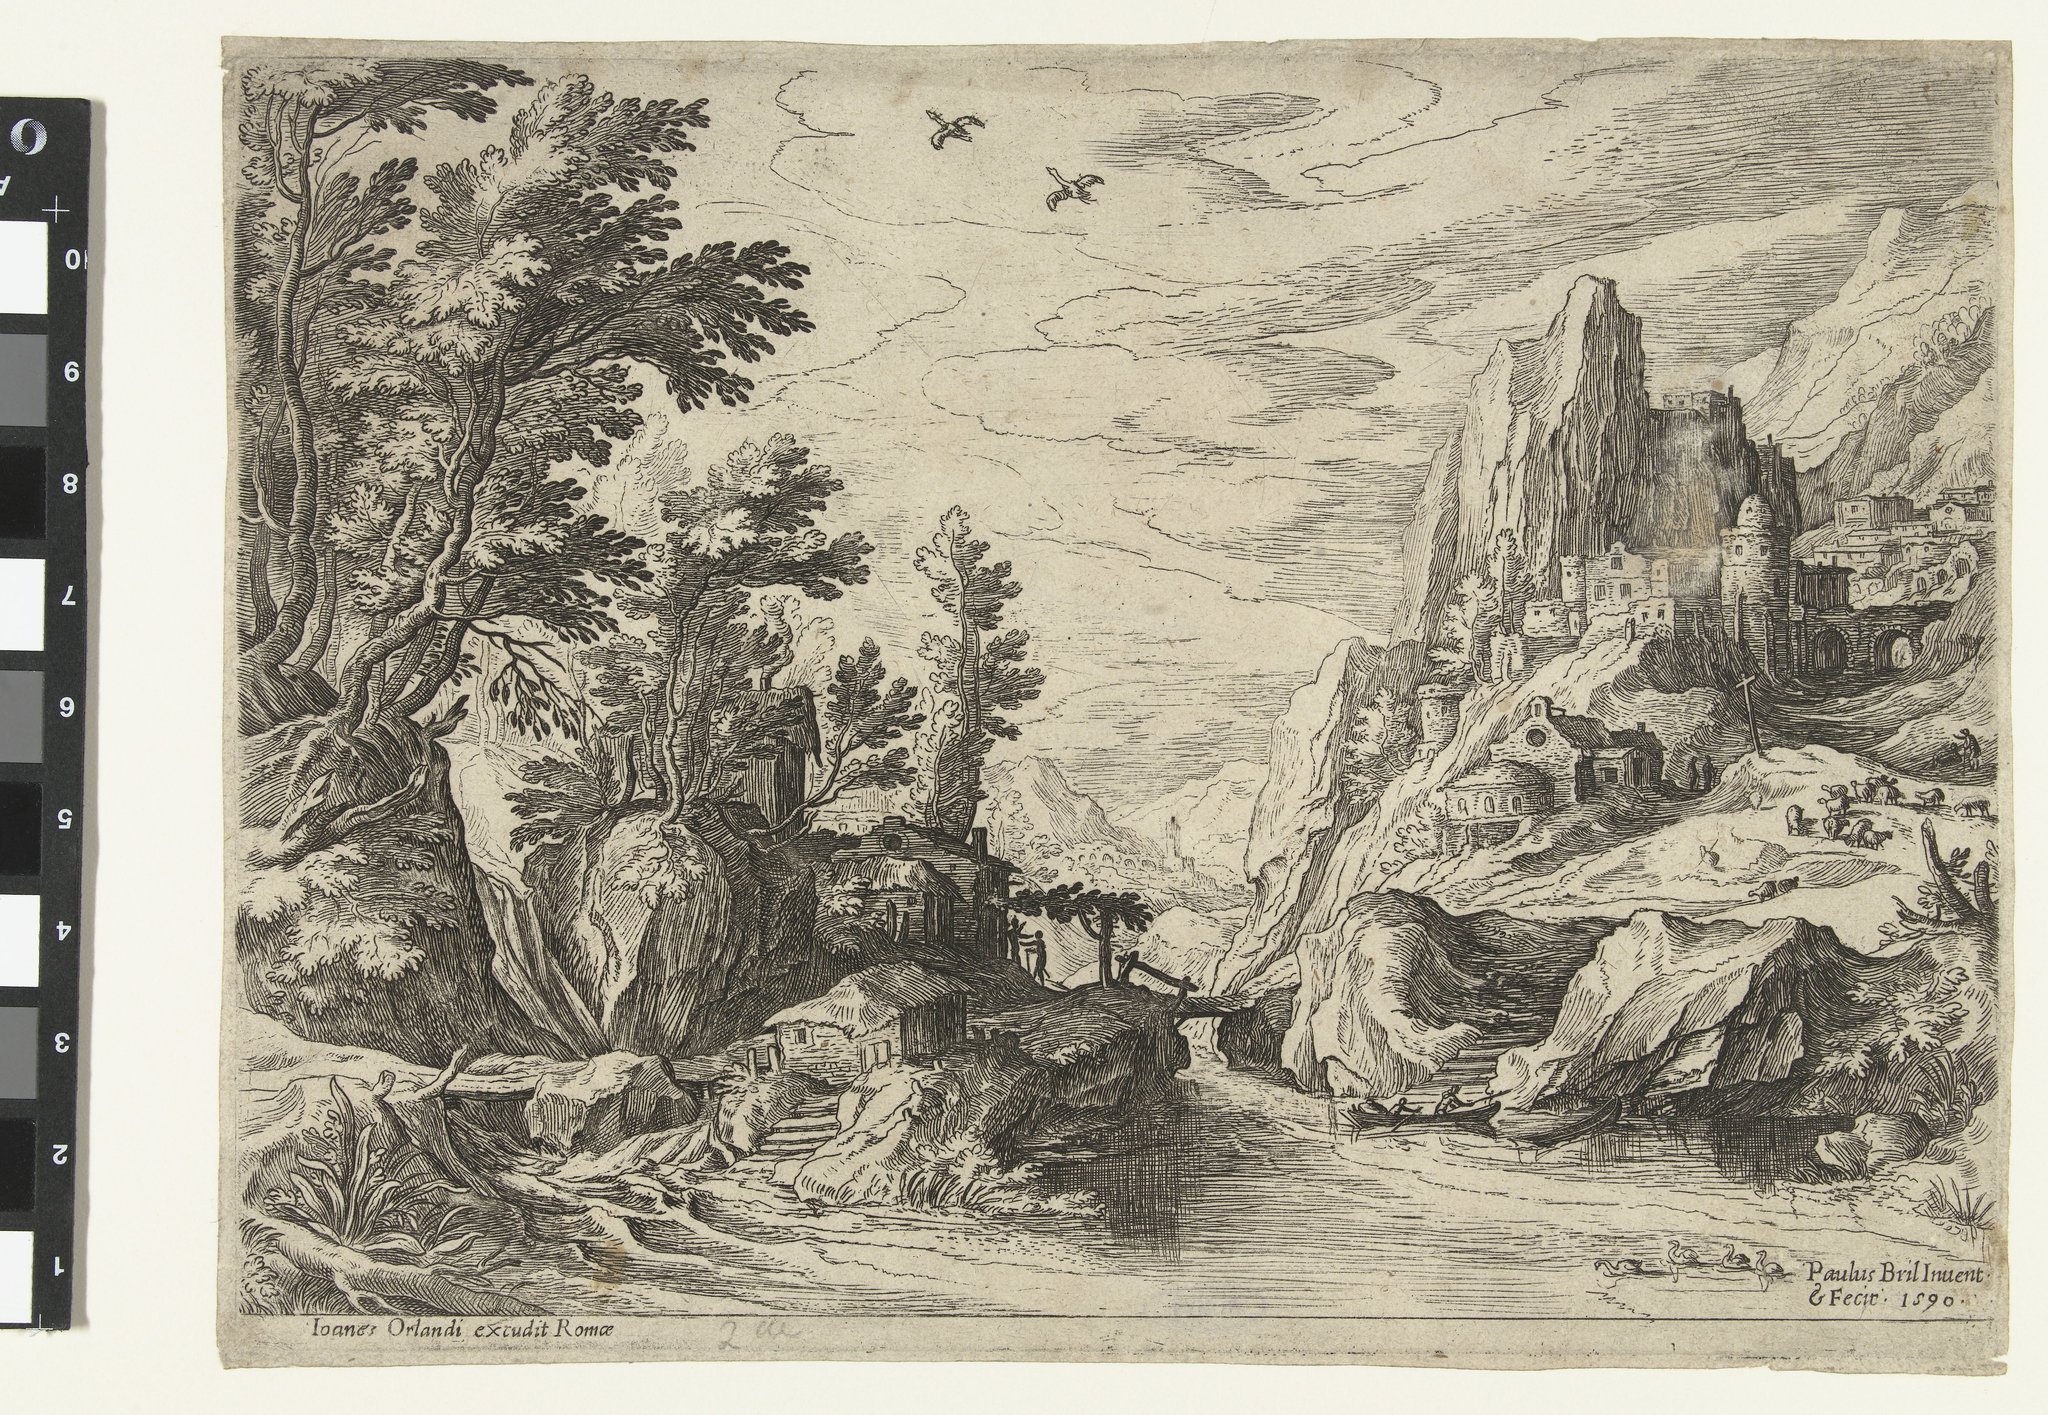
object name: print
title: Rivierlandschap in Campania met stad op rotsen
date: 1590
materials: paper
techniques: etching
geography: rome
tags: rocky coast, campania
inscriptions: collector's mark: Lugt 2228a